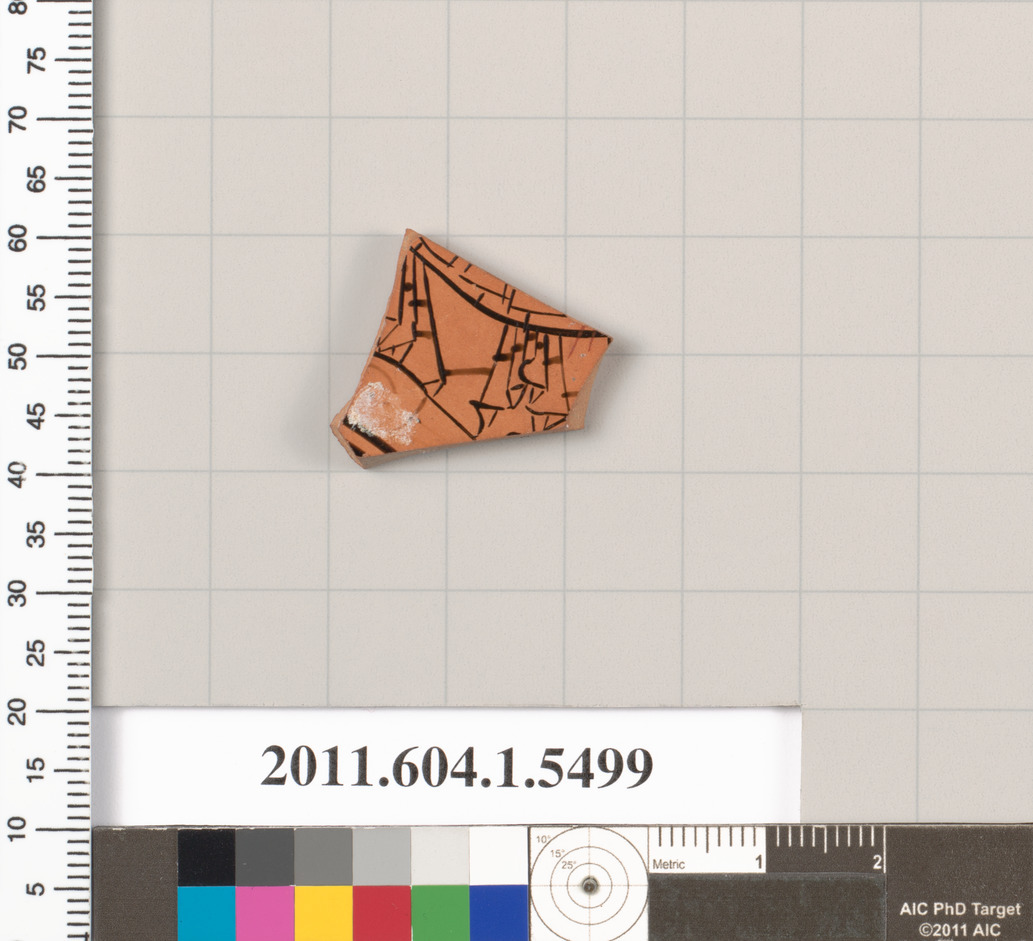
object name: kylix fragment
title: Terracotta fragment of a kylix (drinking cup)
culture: greek, attic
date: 510-490 BCE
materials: terracotta